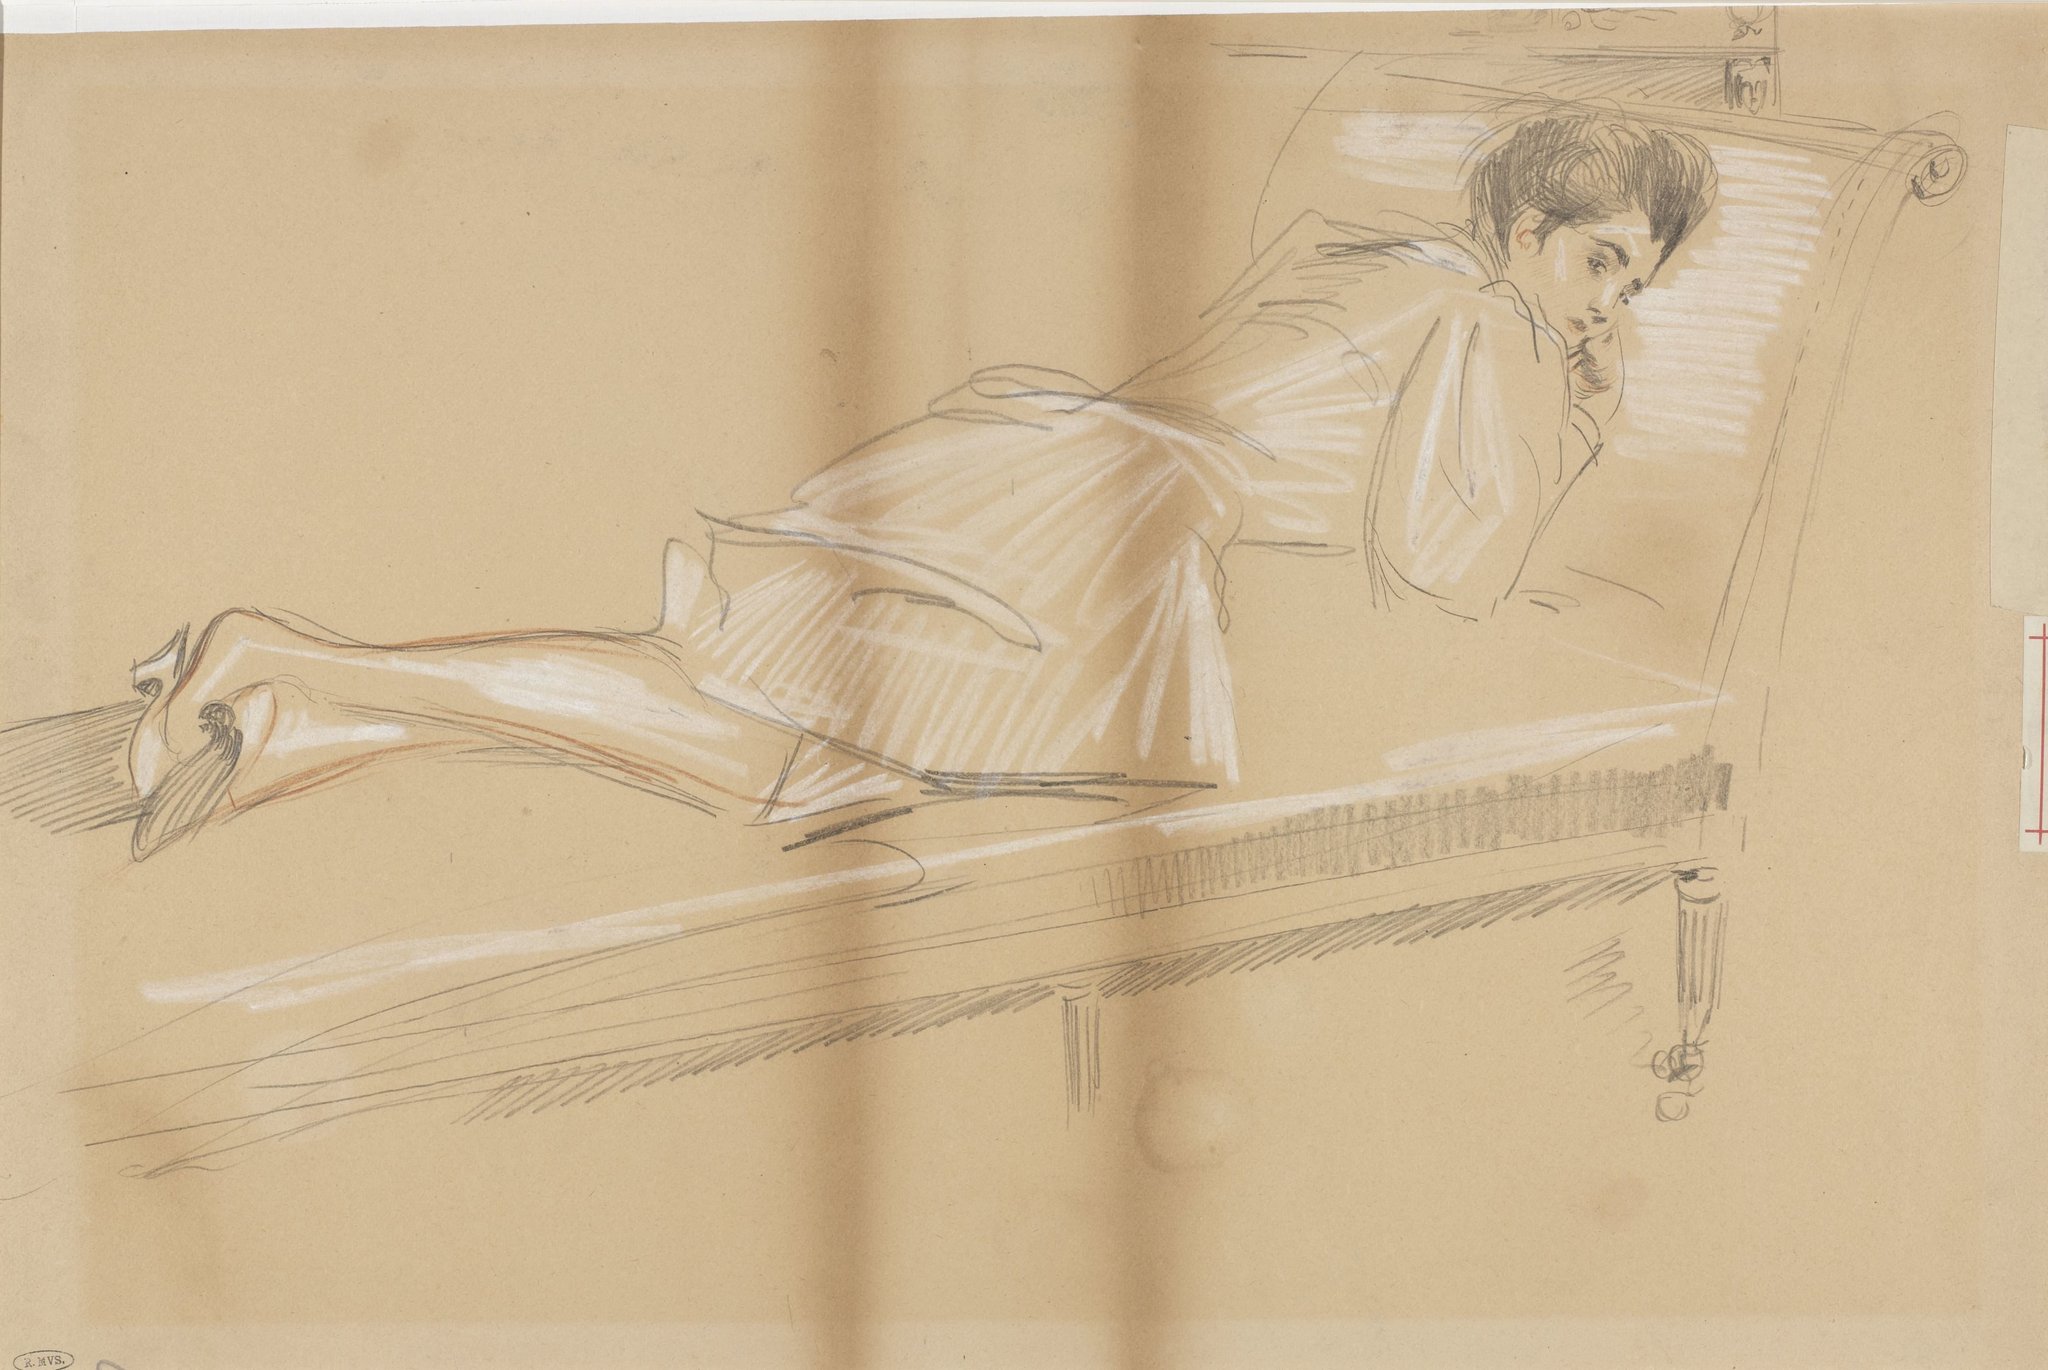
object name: drawing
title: Vrouw voorover liggend op rustbank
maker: paul césar helleu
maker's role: draughtsman, painter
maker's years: 1859-1927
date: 1849-1927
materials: cardboard, chalk, pastel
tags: lying face downwards with hands under the head - aa - female human figure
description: Schets van een jong meisje, voorover liggend op een sofa, het hoofd naar de toeschouwer gekeerd.